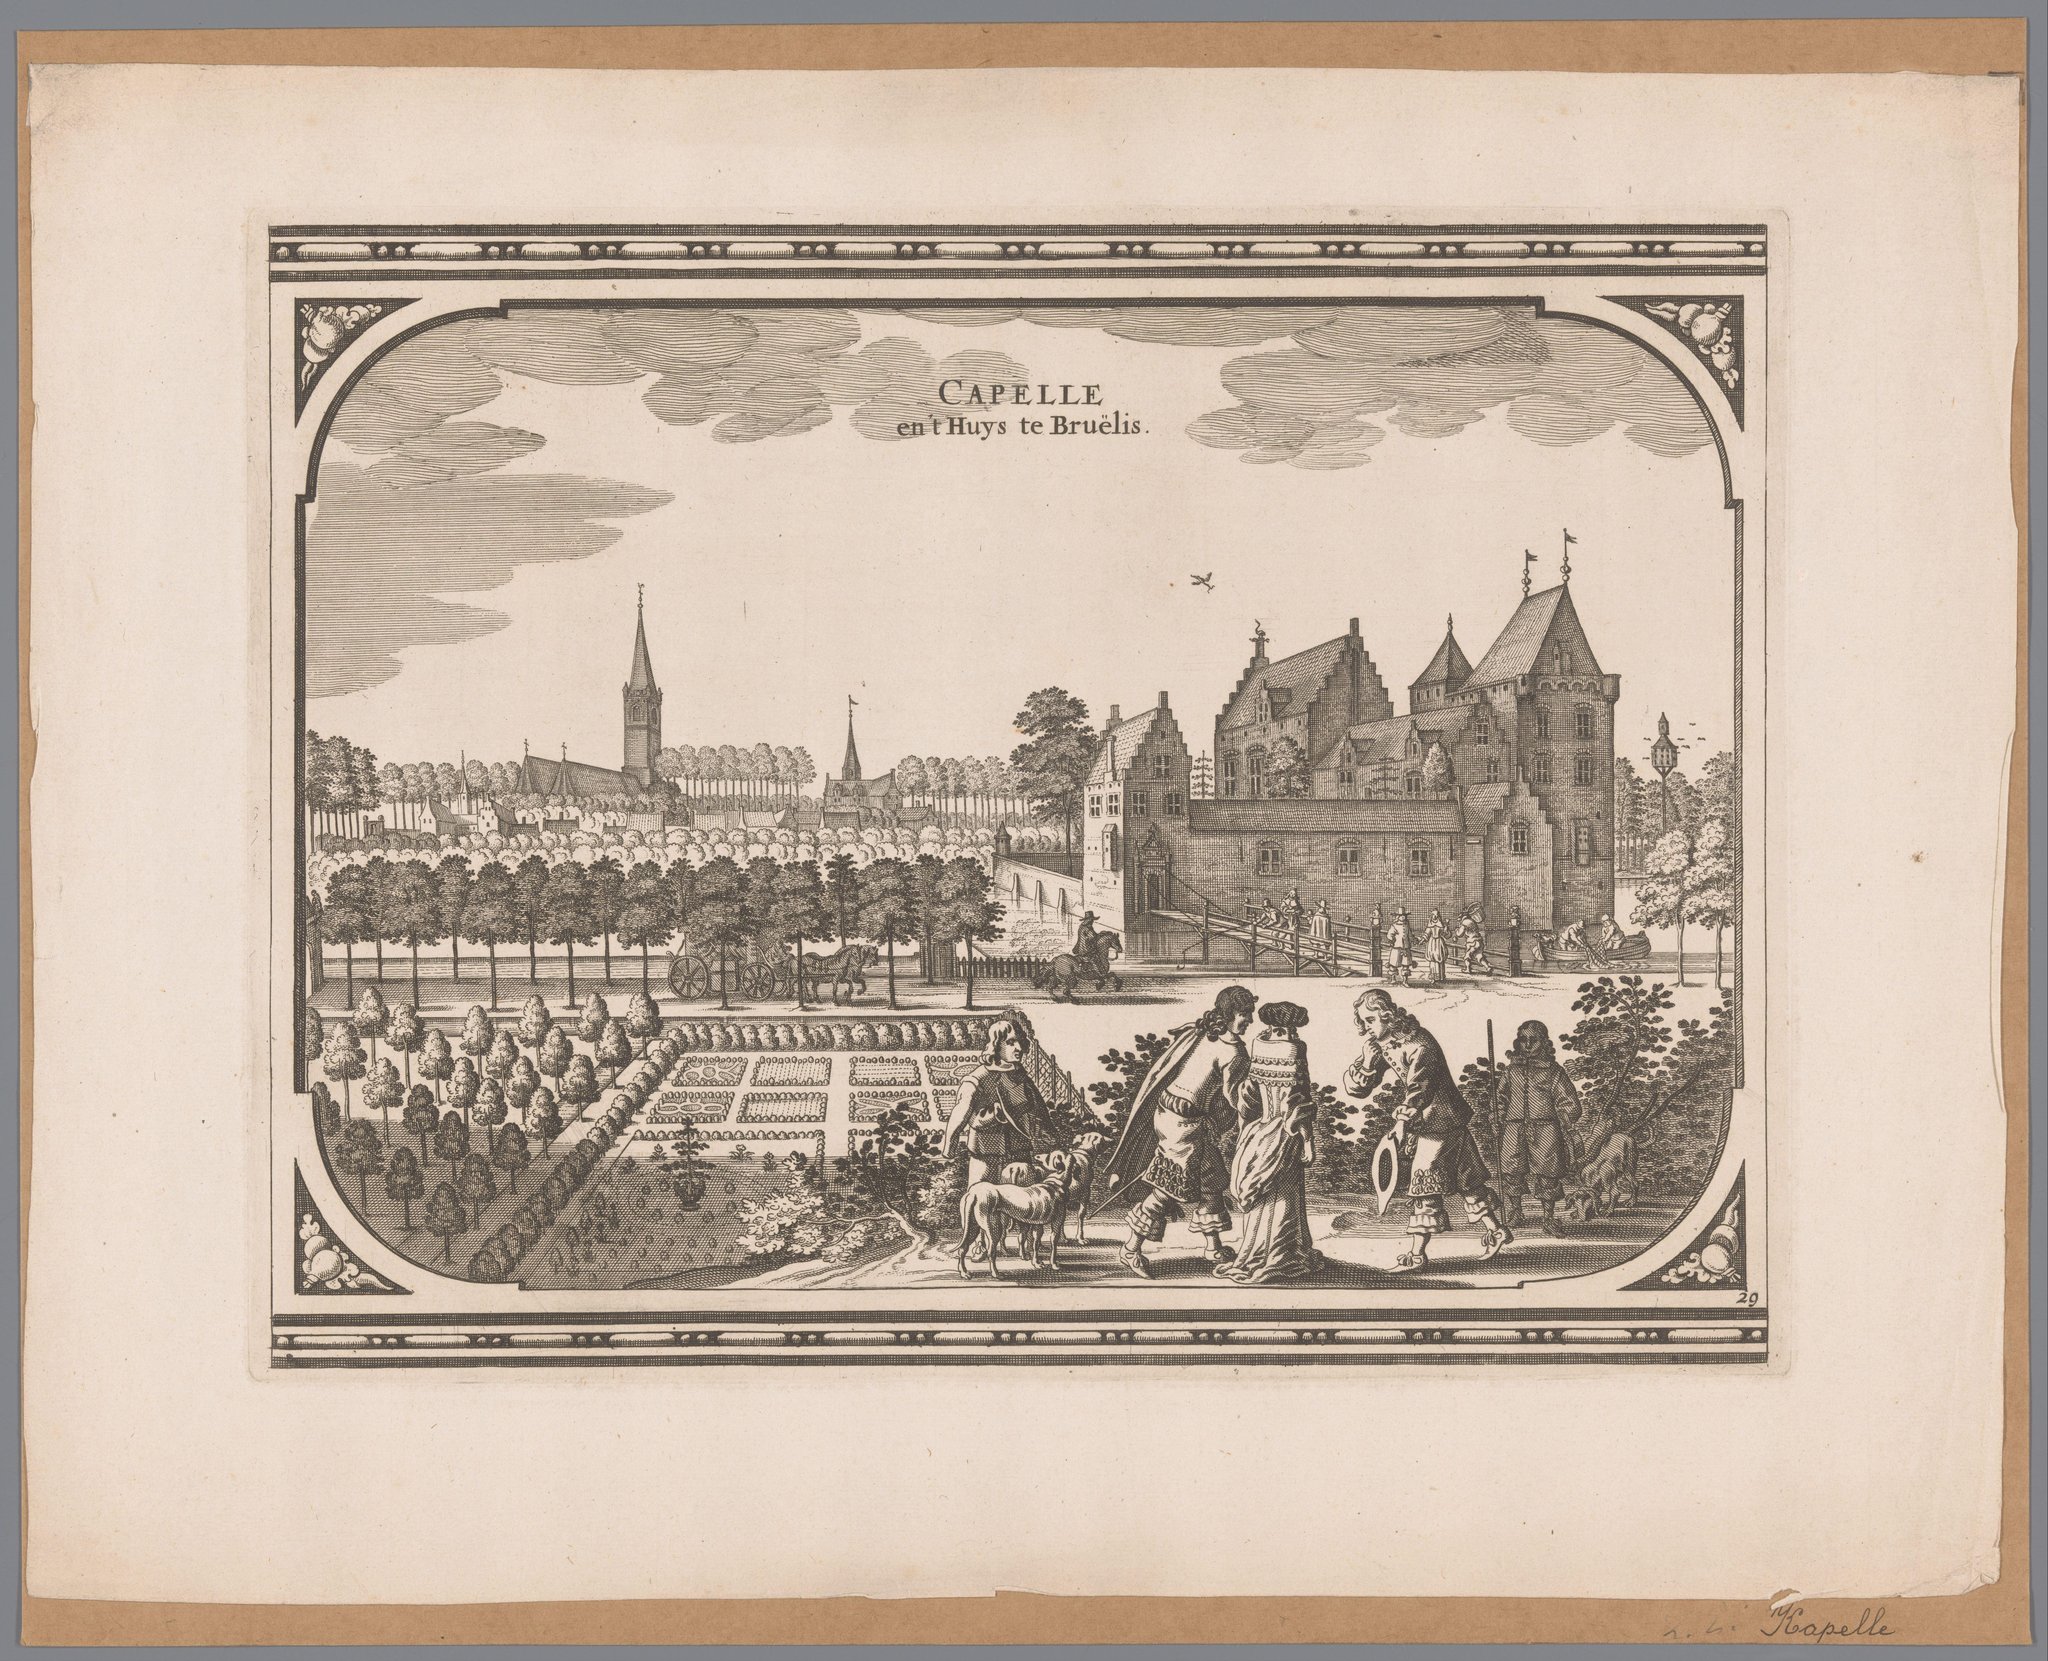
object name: print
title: Gezicht op Kapelle en Kasteel Bruëlis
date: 1662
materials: paper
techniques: engraving, etching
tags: prospect of village, silhouette of village, castle, church (exterior)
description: Prent uit: Speculum Zelandiae dat is een beschryvinge ofte afbeelding der steden, ambachts-heerlijckheden, dorpen, castelen, ridderlijcke hofsteden, huysen en gebouwen gelegen inde eylanden en de graeflijckheyt van Zeelandt, bij een vergadert' door Nicolaus Visscher. S.l.: Nicolaes Visscher, [1662]. Verschillende staten van prenten zijn gebruikt in andere uitgaven van 'Speculum Zelandiae' en in andere publicaties uitgegeven door Zacharias Roman en Nicolaes Visscher (I). Verwarring rondom de datering kan ontstaan door het feit dat de prenten uit 'Speculum Zelandiae' ook voorkomen in eerder uitgegeven publicaties, waar ze later in zijn ingebonden. Zo komen prenten uitgegeven door Roman/Visscher voor in sommige exemplaren van: Boxhorn, Marcus Zuerius van. Chroniick van Zeelandt (…). 2 dln. Middelburg: Zacharias Roman, 1644. De door weduwe (Joachim) Ottens en Zoonen uitgegeven prenten zijn later ingebonden in sommige exemplaren van: Smallegange, Mattheus. Nieuwe Cronyk van Zeeland (…). Middelburg en Amsterdam: Johannes Meertens en Abraham van Someren, 1696.